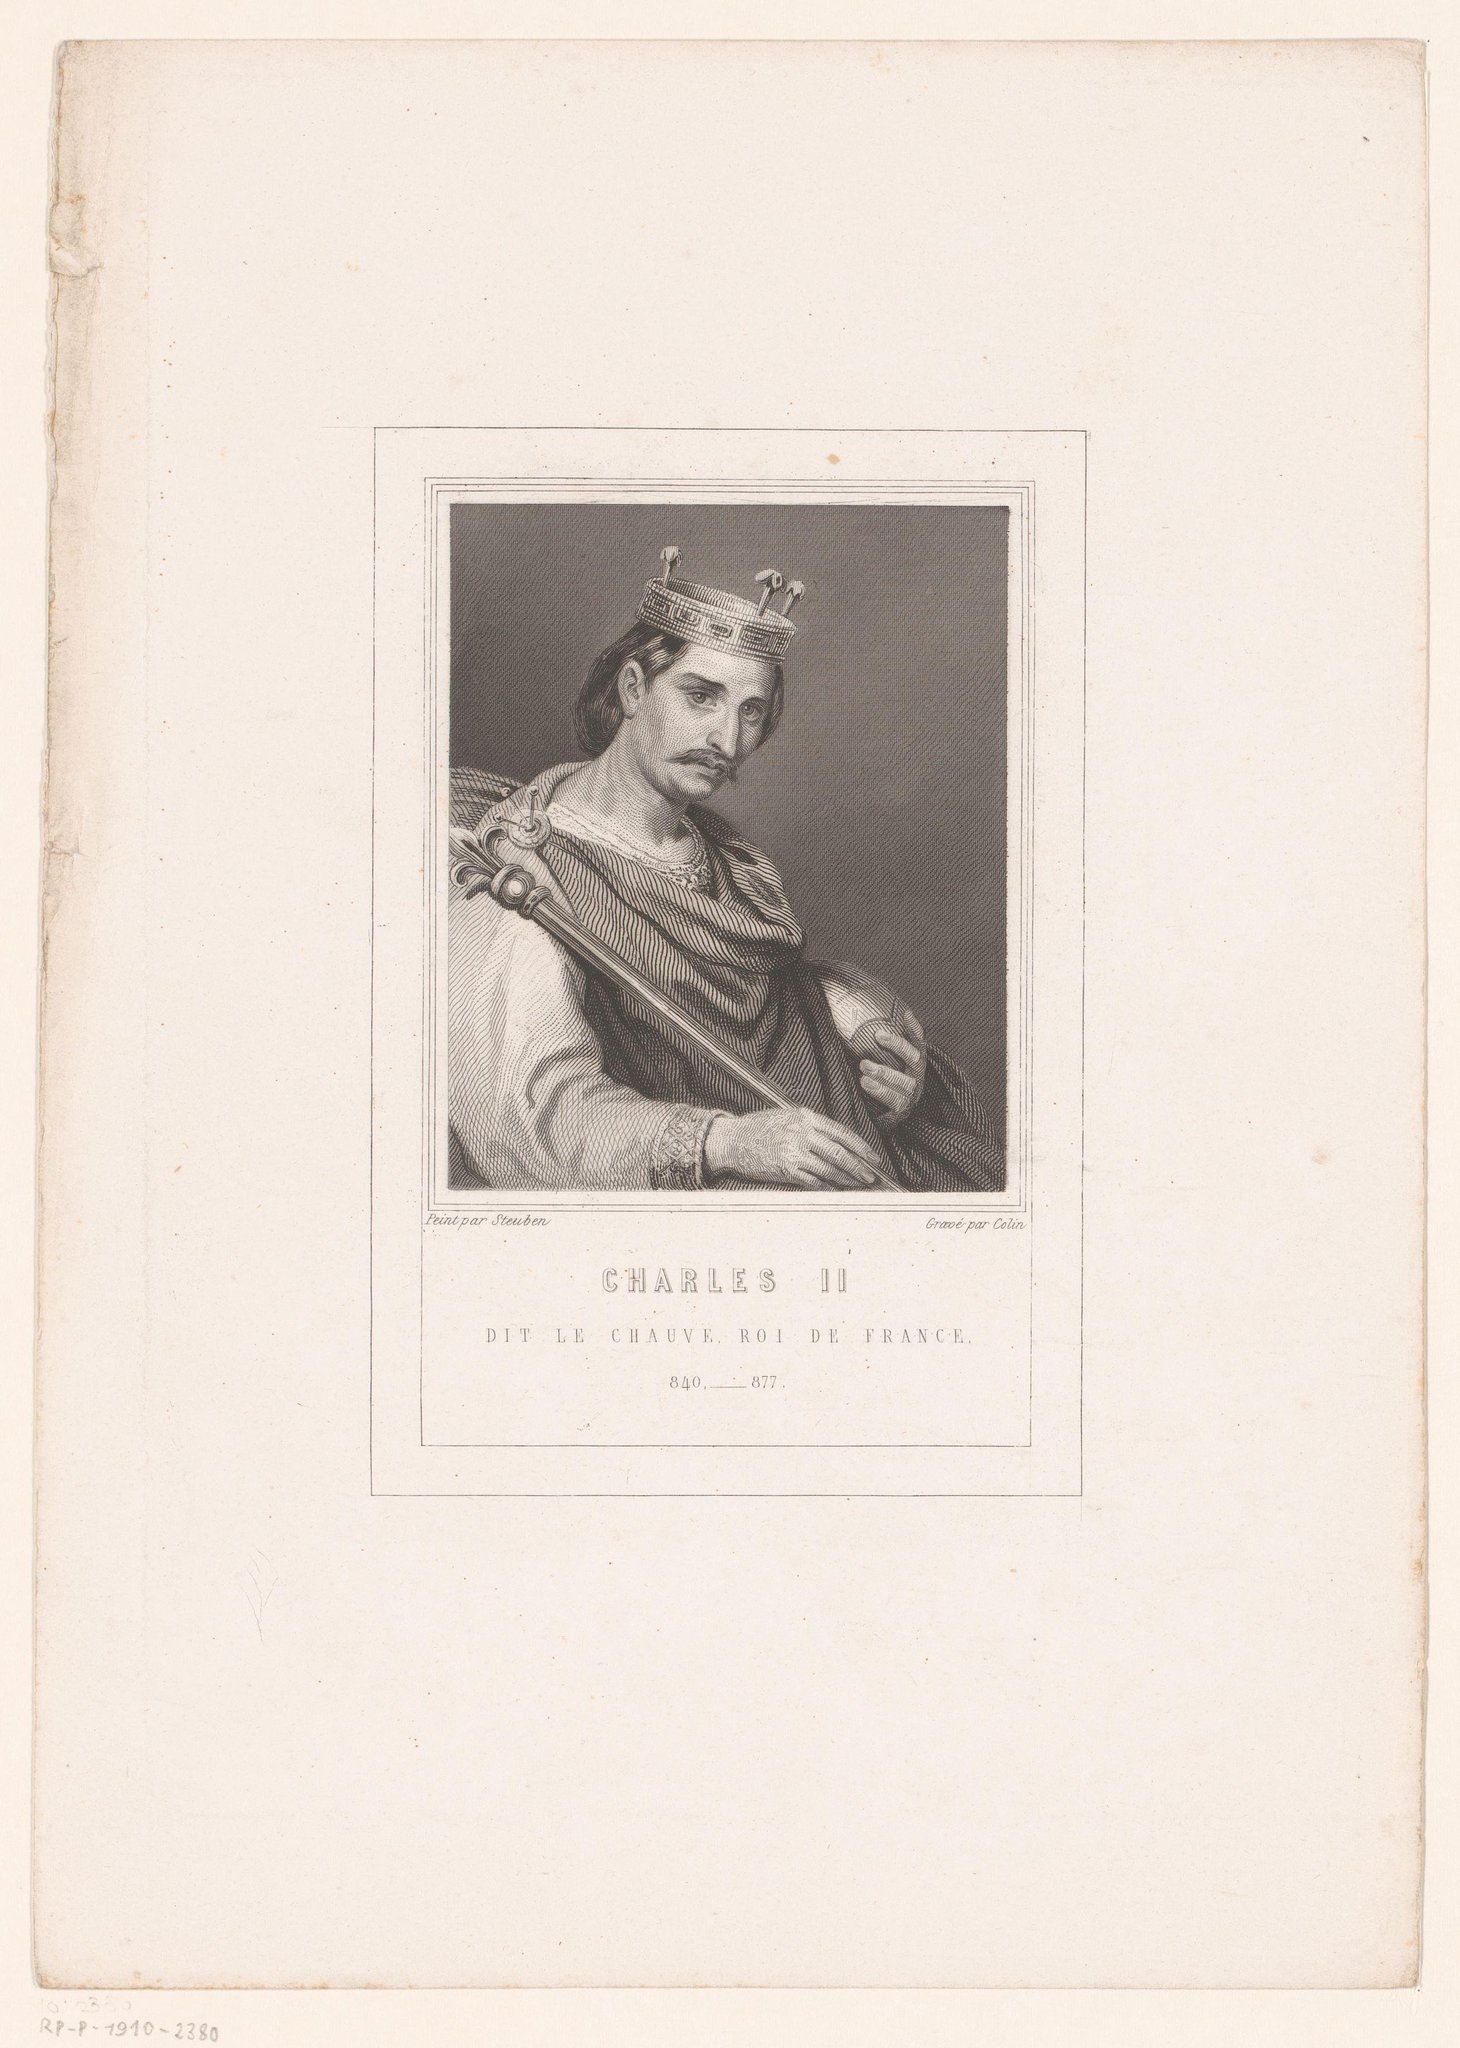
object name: print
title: Charles II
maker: charles amédée colin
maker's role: print maker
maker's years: 1808-1873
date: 1818-1873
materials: paper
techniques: engraving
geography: france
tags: london, karel ii (koning van engeland), historical persons, ruler, sovereign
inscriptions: collector's mark: Lugt 2228